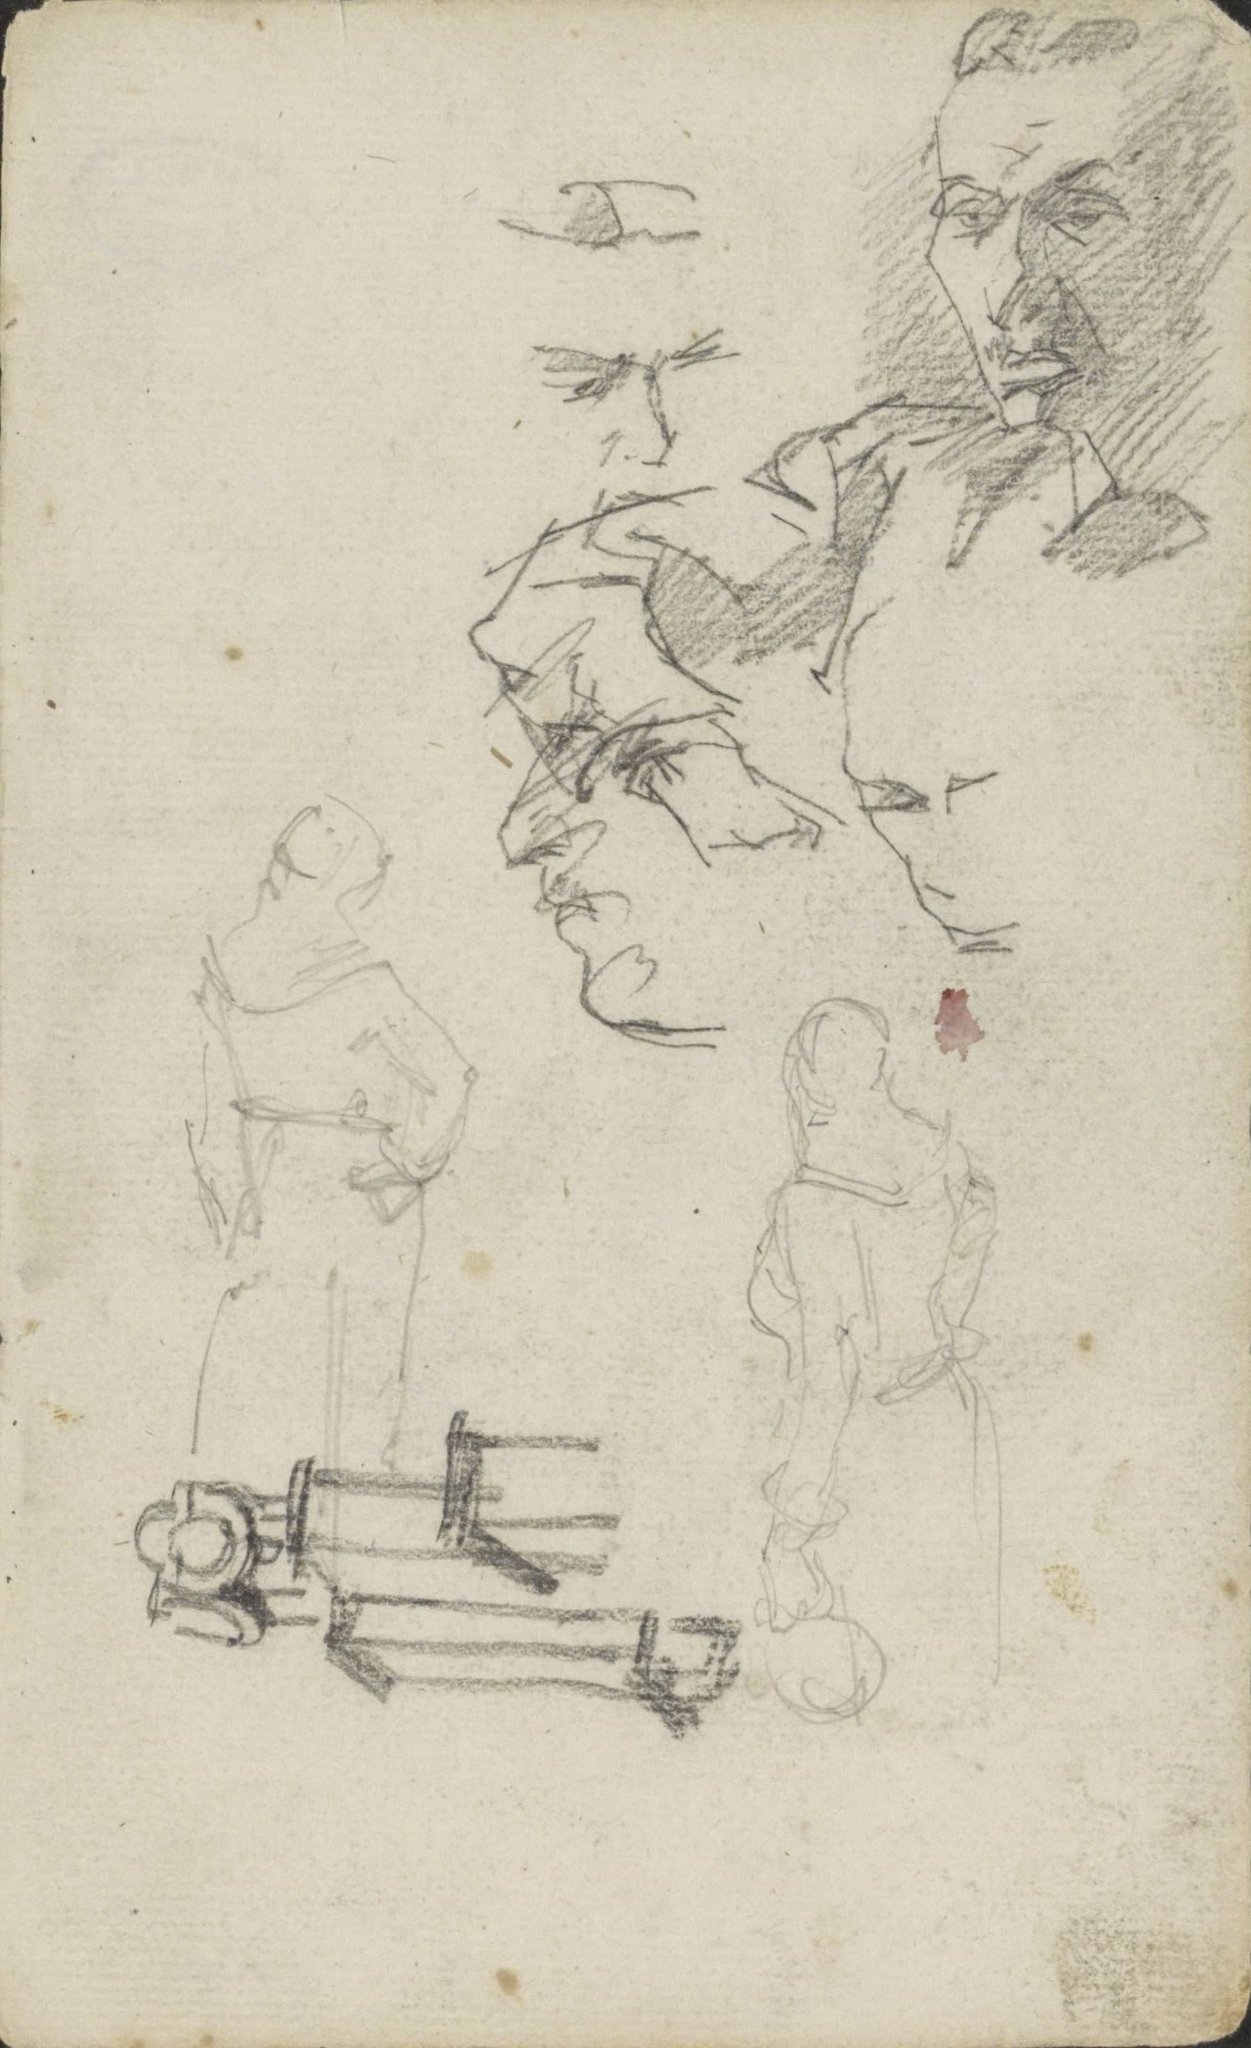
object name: drawing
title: Figuurstudies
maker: george hendrik breitner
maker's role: draughtsman, painter, print maker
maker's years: 1857-1923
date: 1886-1923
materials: chalk, paper, pencil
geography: amsterdam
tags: head (human), postures of the human figure - aa - female human figure